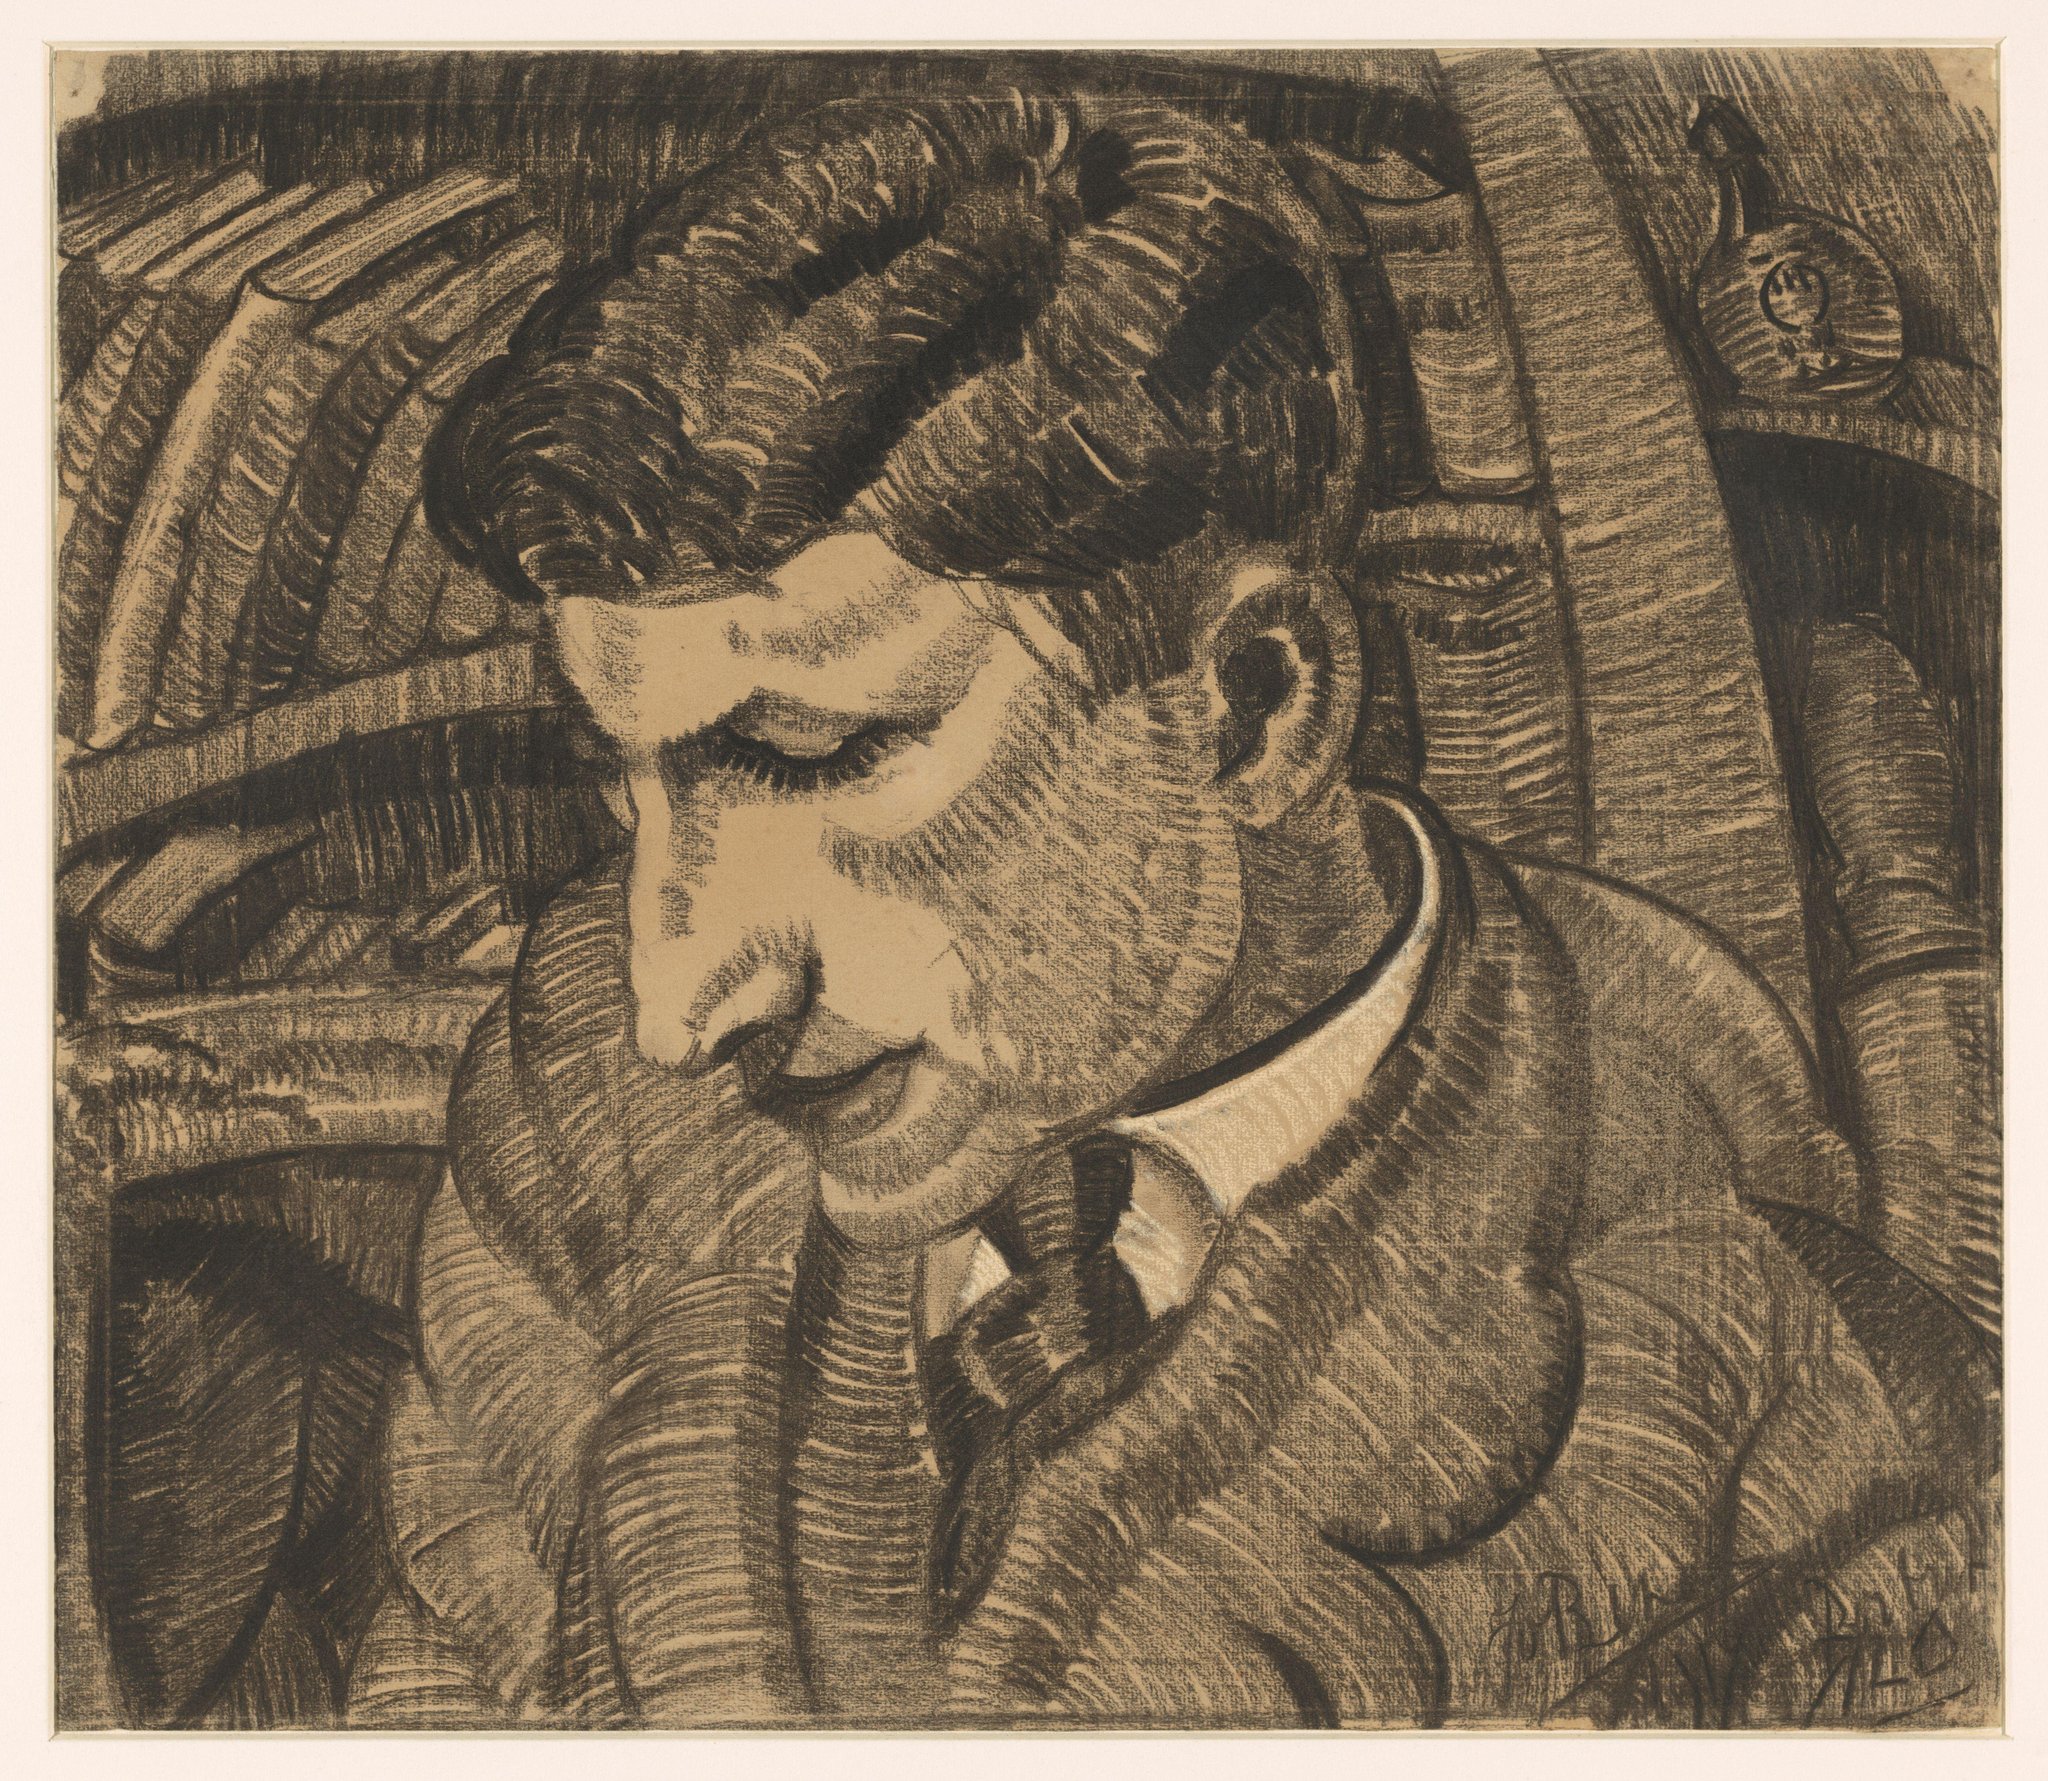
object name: drawing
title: Jongeman in een studeerkamer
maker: jo bezaan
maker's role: draughtsman, print maker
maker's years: 1894-1952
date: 1917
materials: chalk, paper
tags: anonymous historical person portrayed alone, male sex; man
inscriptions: collector's mark: Lugt 2228